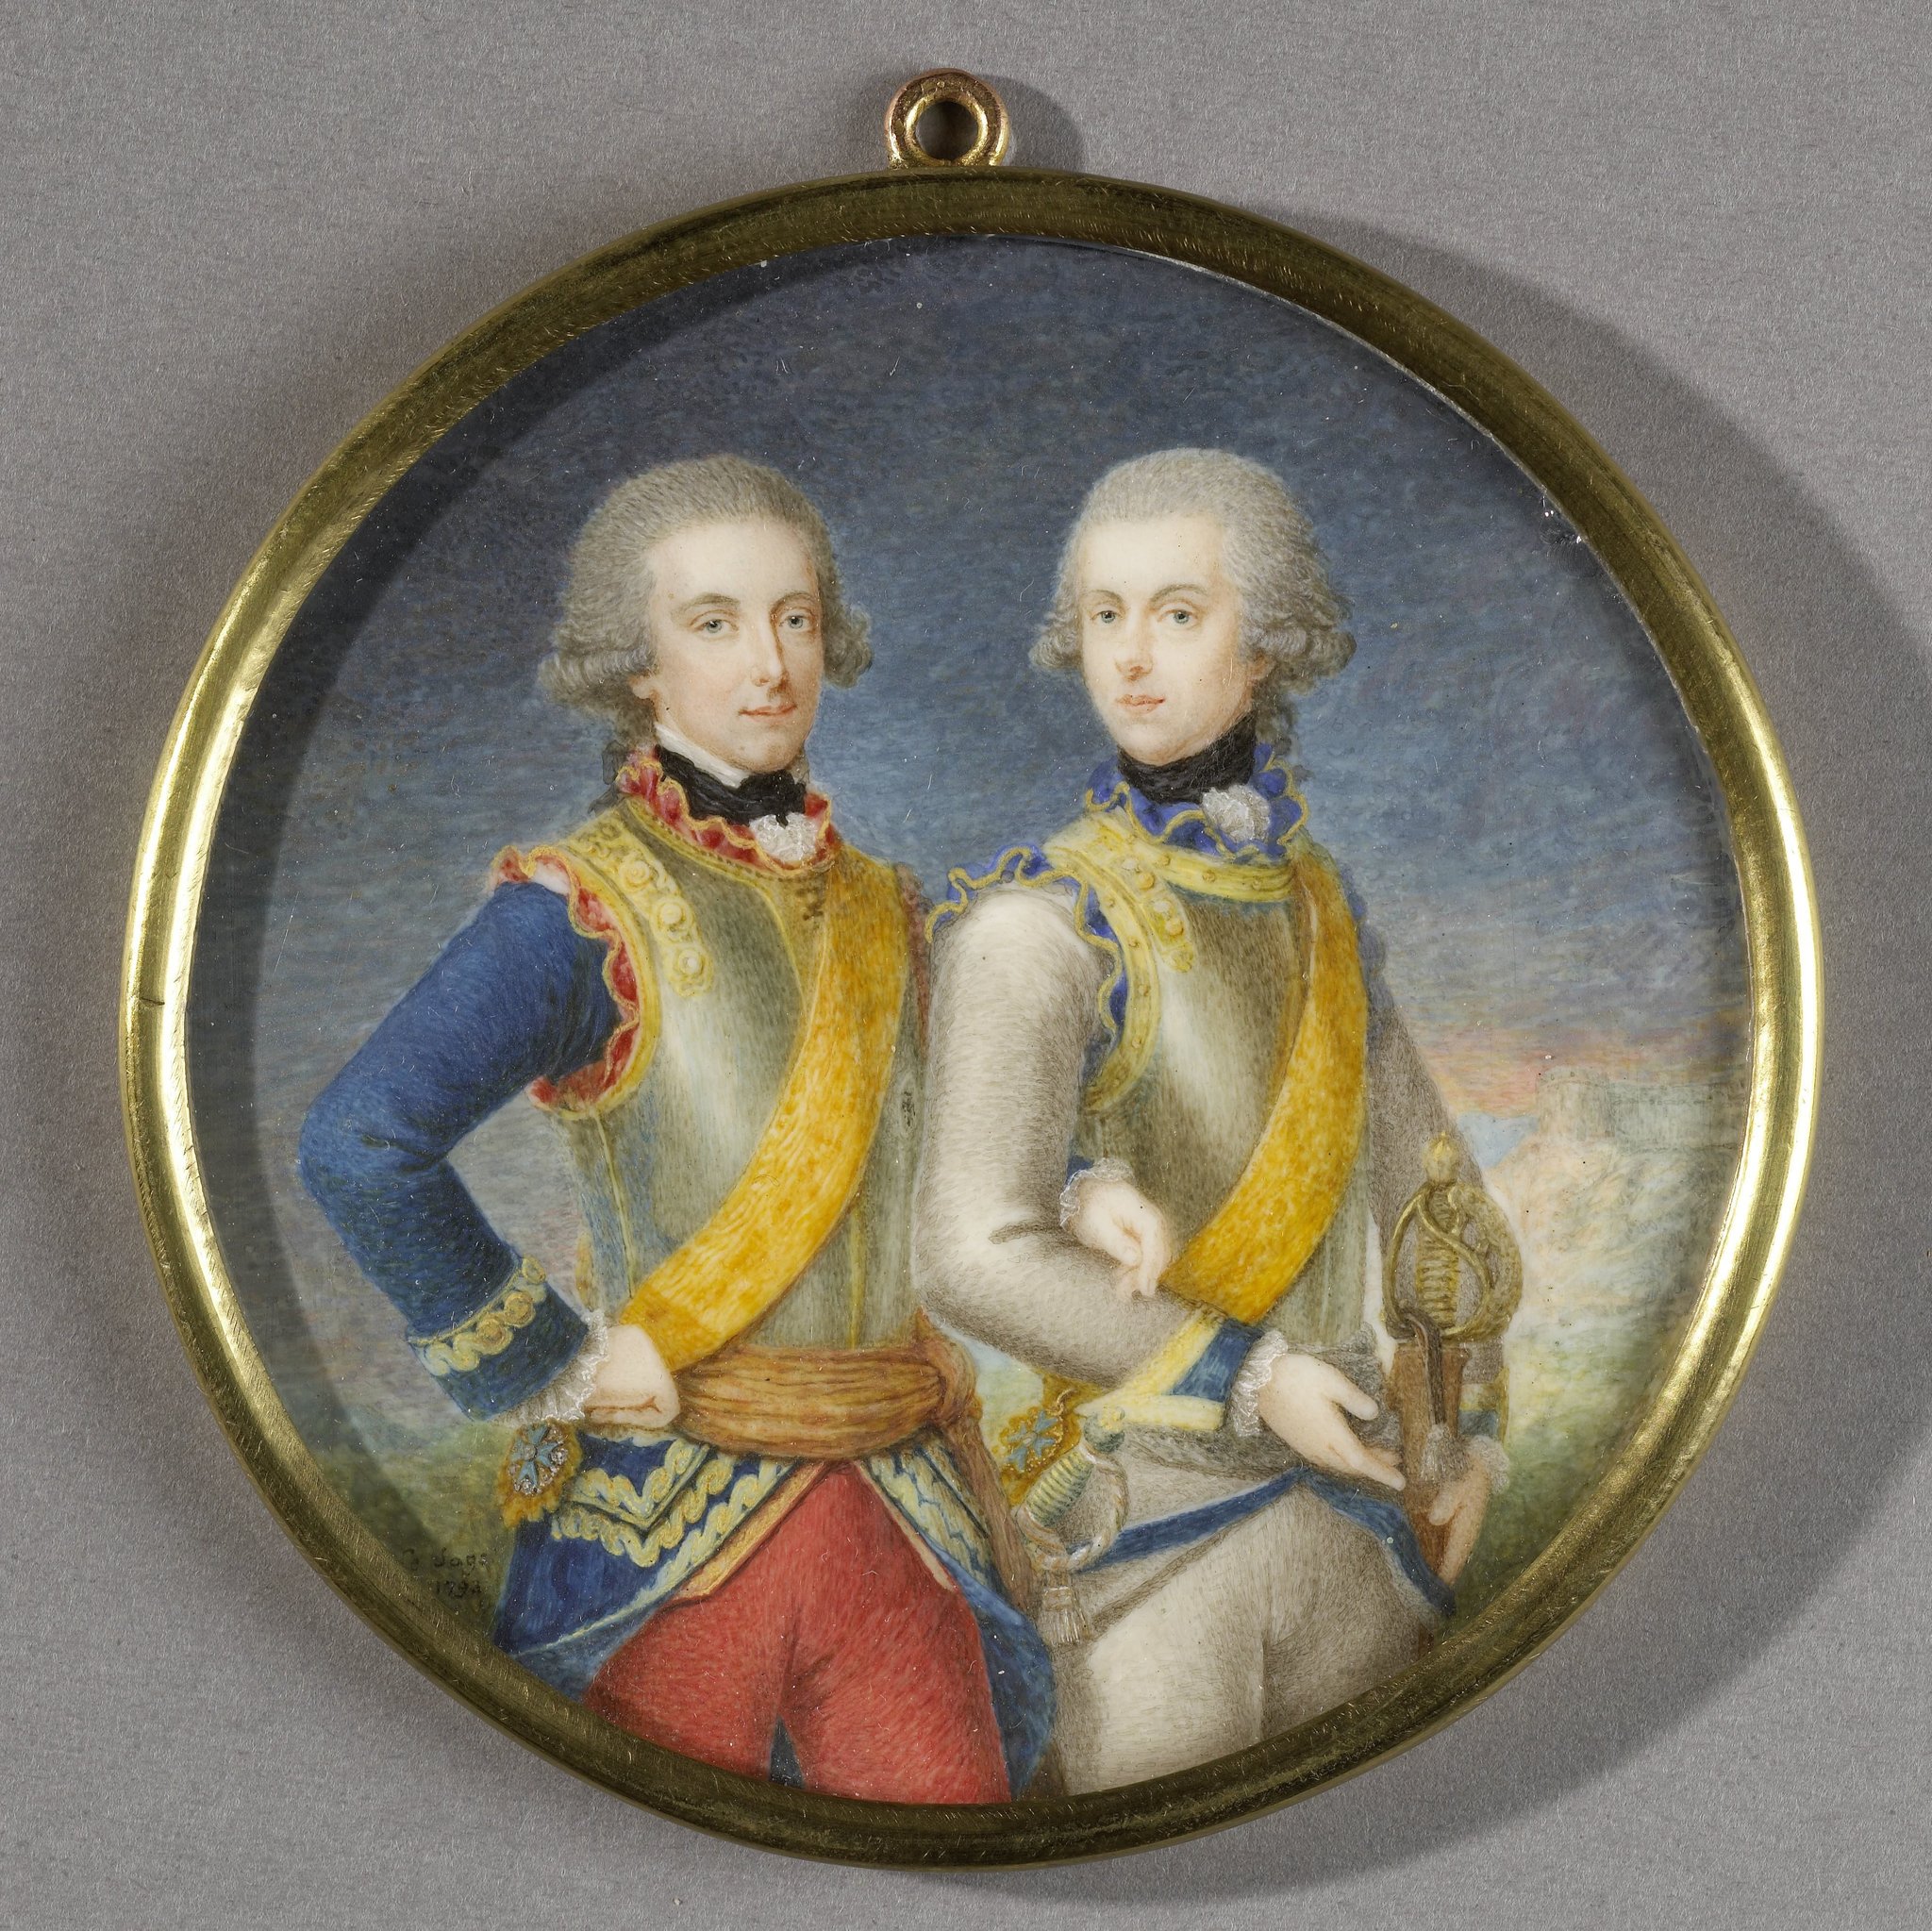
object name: painting, miniature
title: Willem Frederik (1772-1843), prins van Oranje-Nassau, met zijn jongere broer Willem George Frederik (1774-99)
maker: pieter le sage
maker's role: miniatuurschilder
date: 1793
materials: copper, glass, ivory, oil, paint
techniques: forging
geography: netherlands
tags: the hague, berlin, william i of the netherlands, willem george frederik (prins van oranje-nassau), prince, historical persons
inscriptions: signature and date: ‘Le Sage 1793’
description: William Frederick with his cousin Ludwig Ferdinand of Prussia.